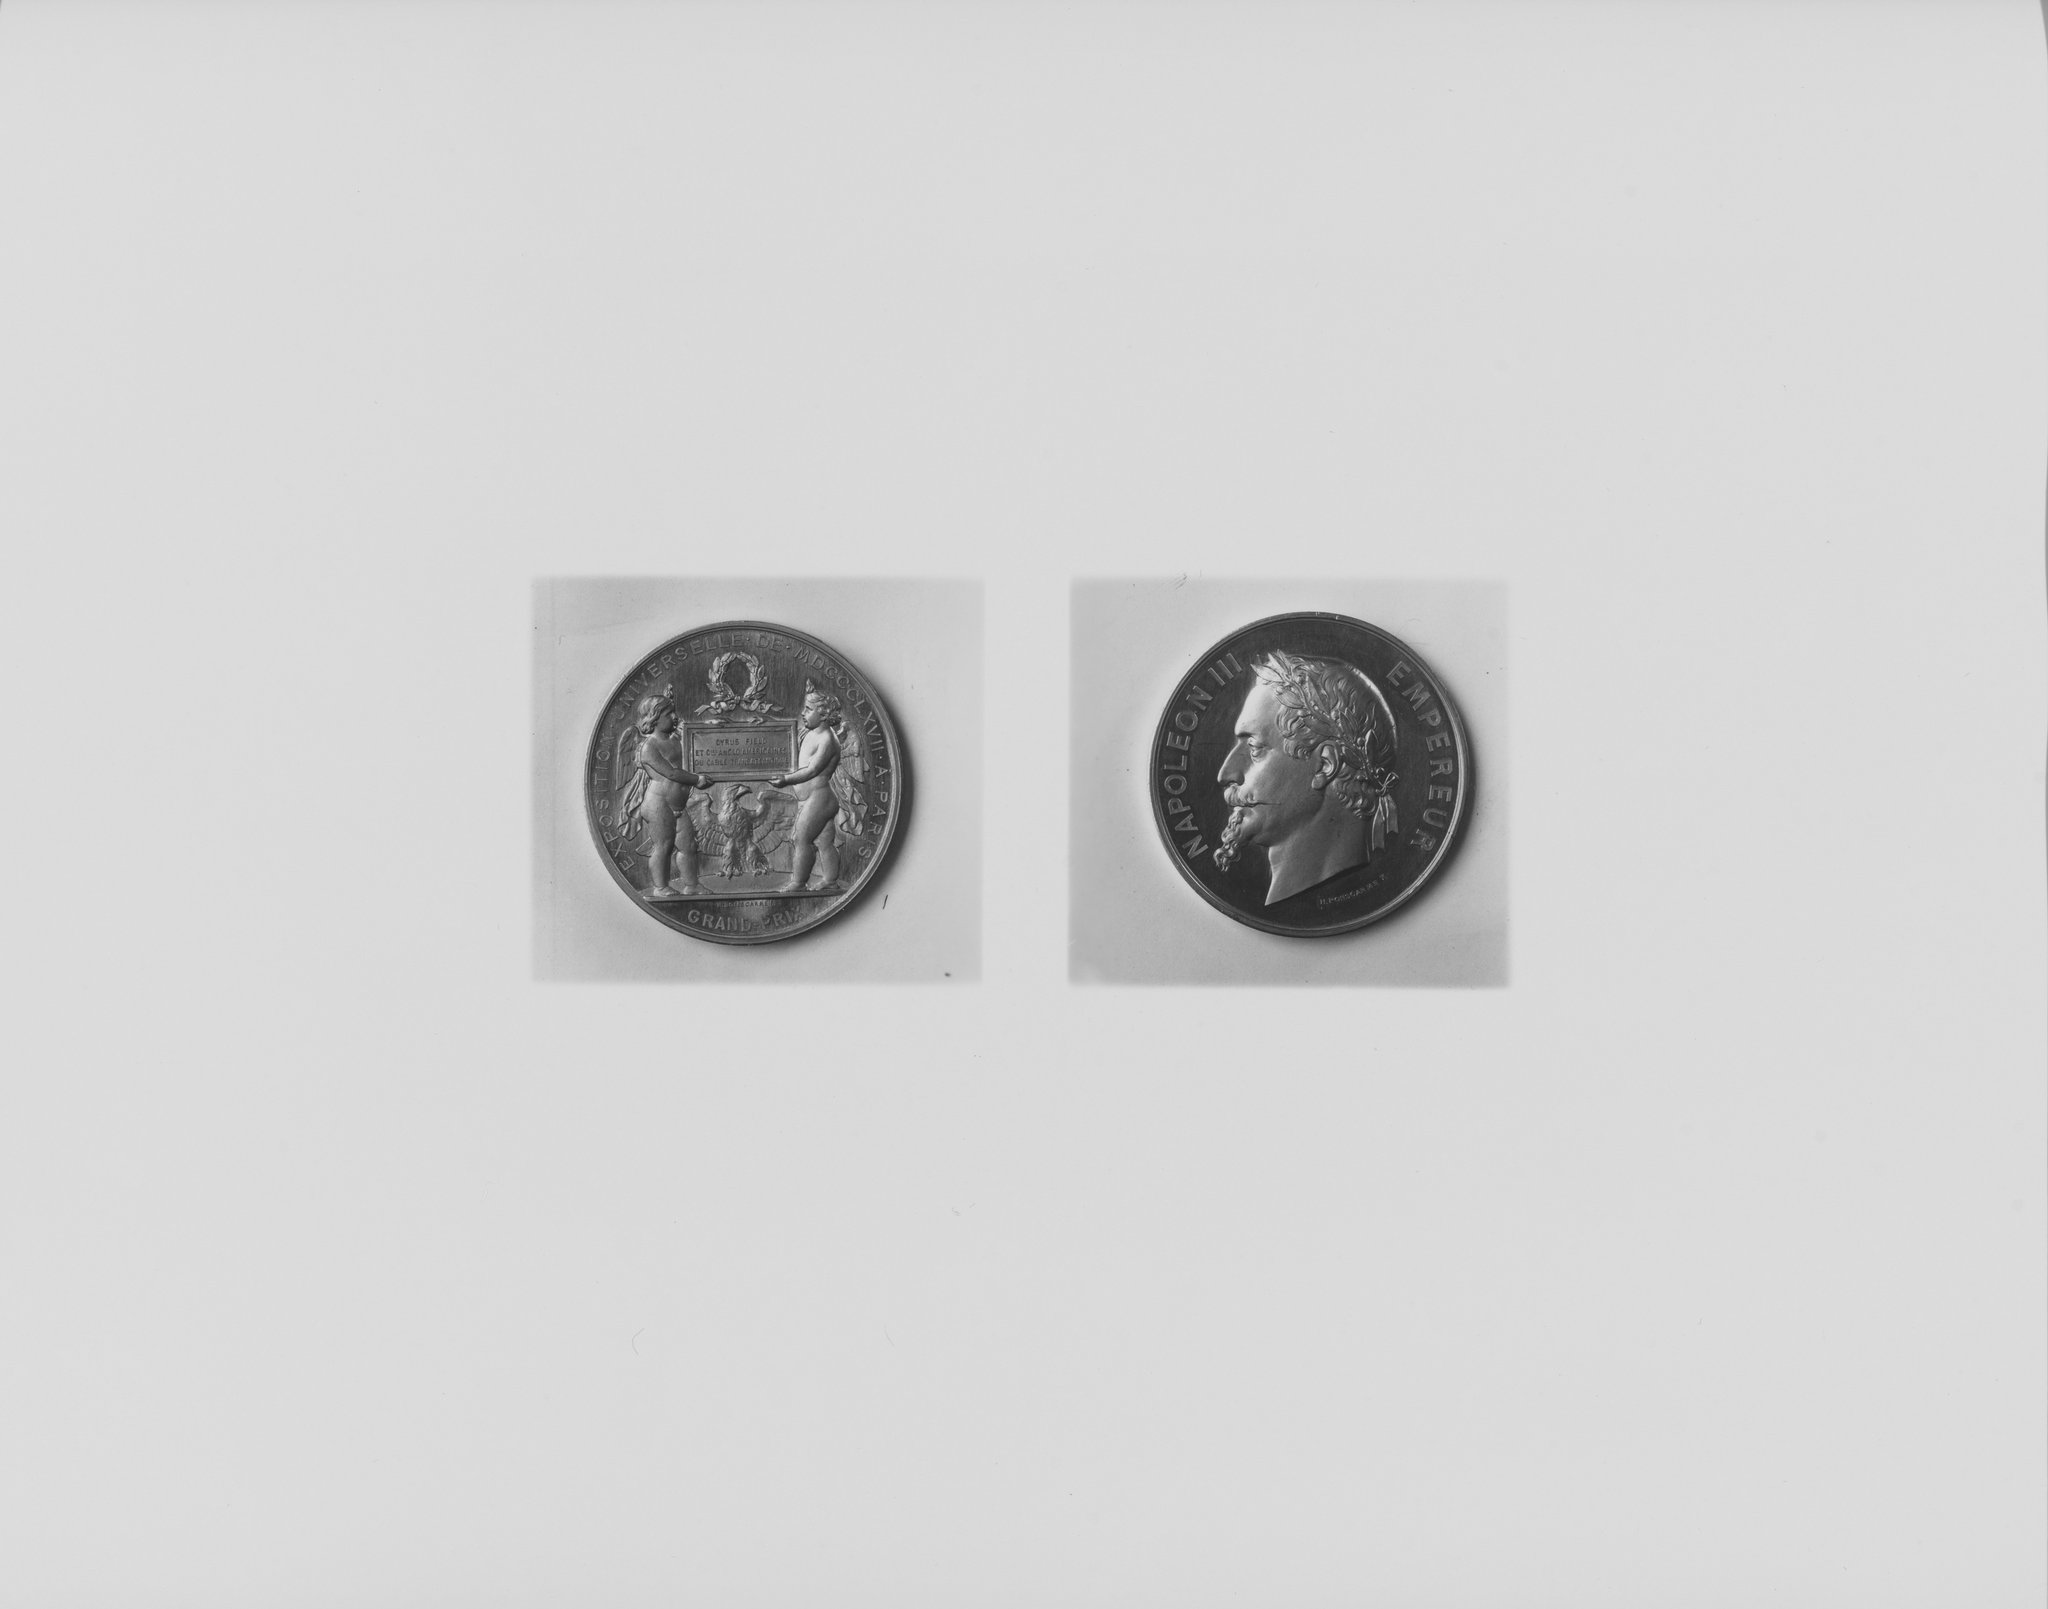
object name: medal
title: To C.W. Field, and his Telegraph Companies, Universal Exhibition, Paris, 1867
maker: françois-joseph-hubert ponscarme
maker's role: artist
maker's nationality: french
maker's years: 1827-1903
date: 1867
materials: gold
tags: eagles,napoleon iii,profiles,coat of arms